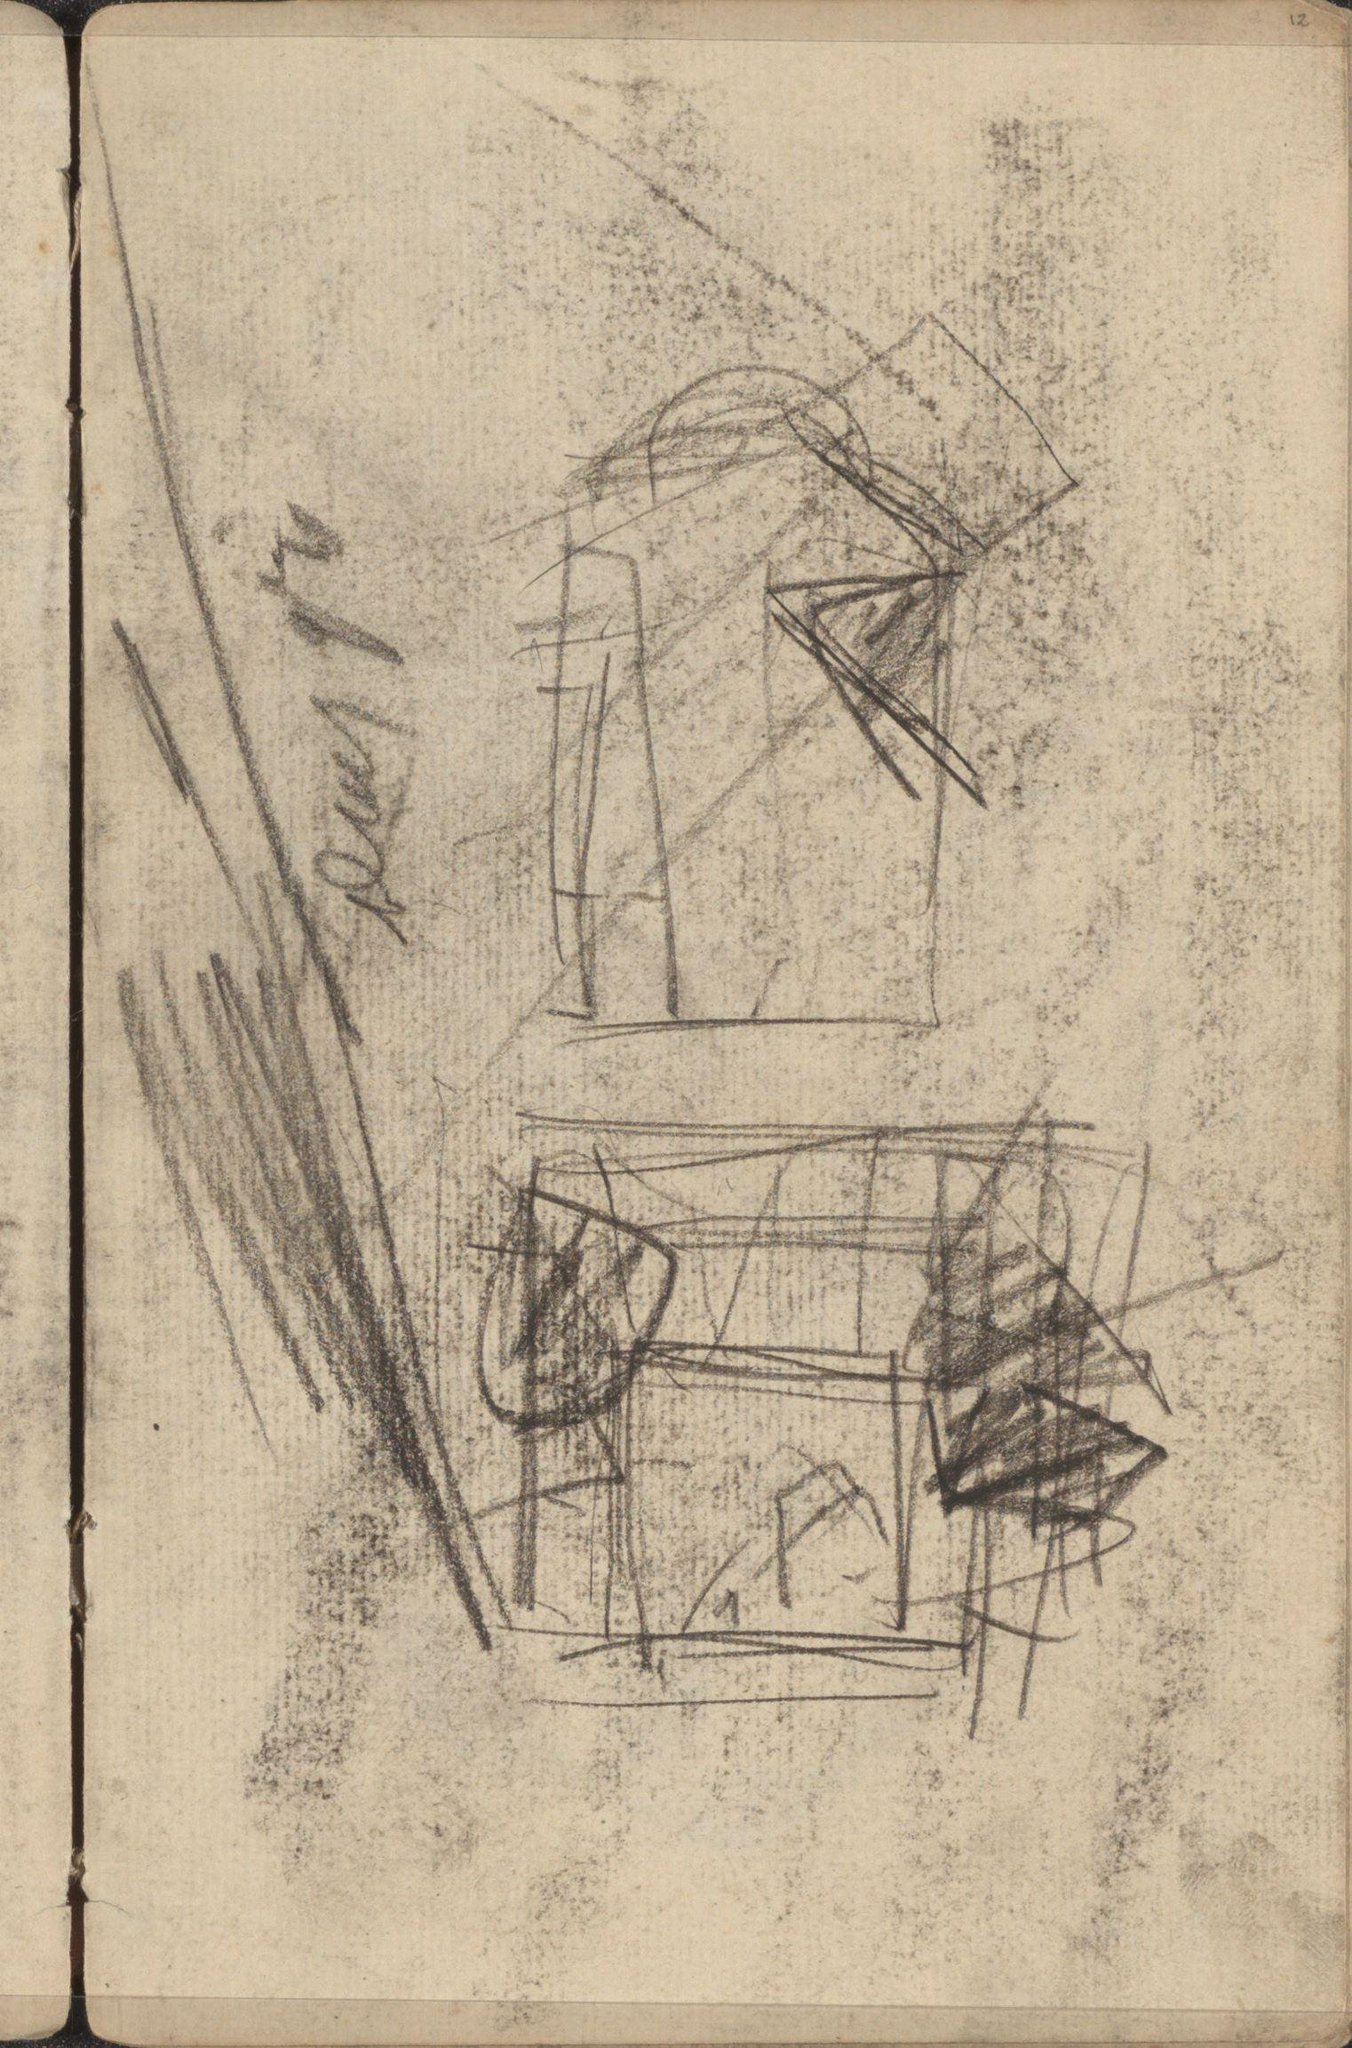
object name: sketchbook leaf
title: Studieblad, mogelijk met een schouw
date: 1883-1885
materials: chalk, paper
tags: chimney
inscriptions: kleurnotitie, handgeschreven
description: Pagina 12 uit een schetsboek met 16 bladen.